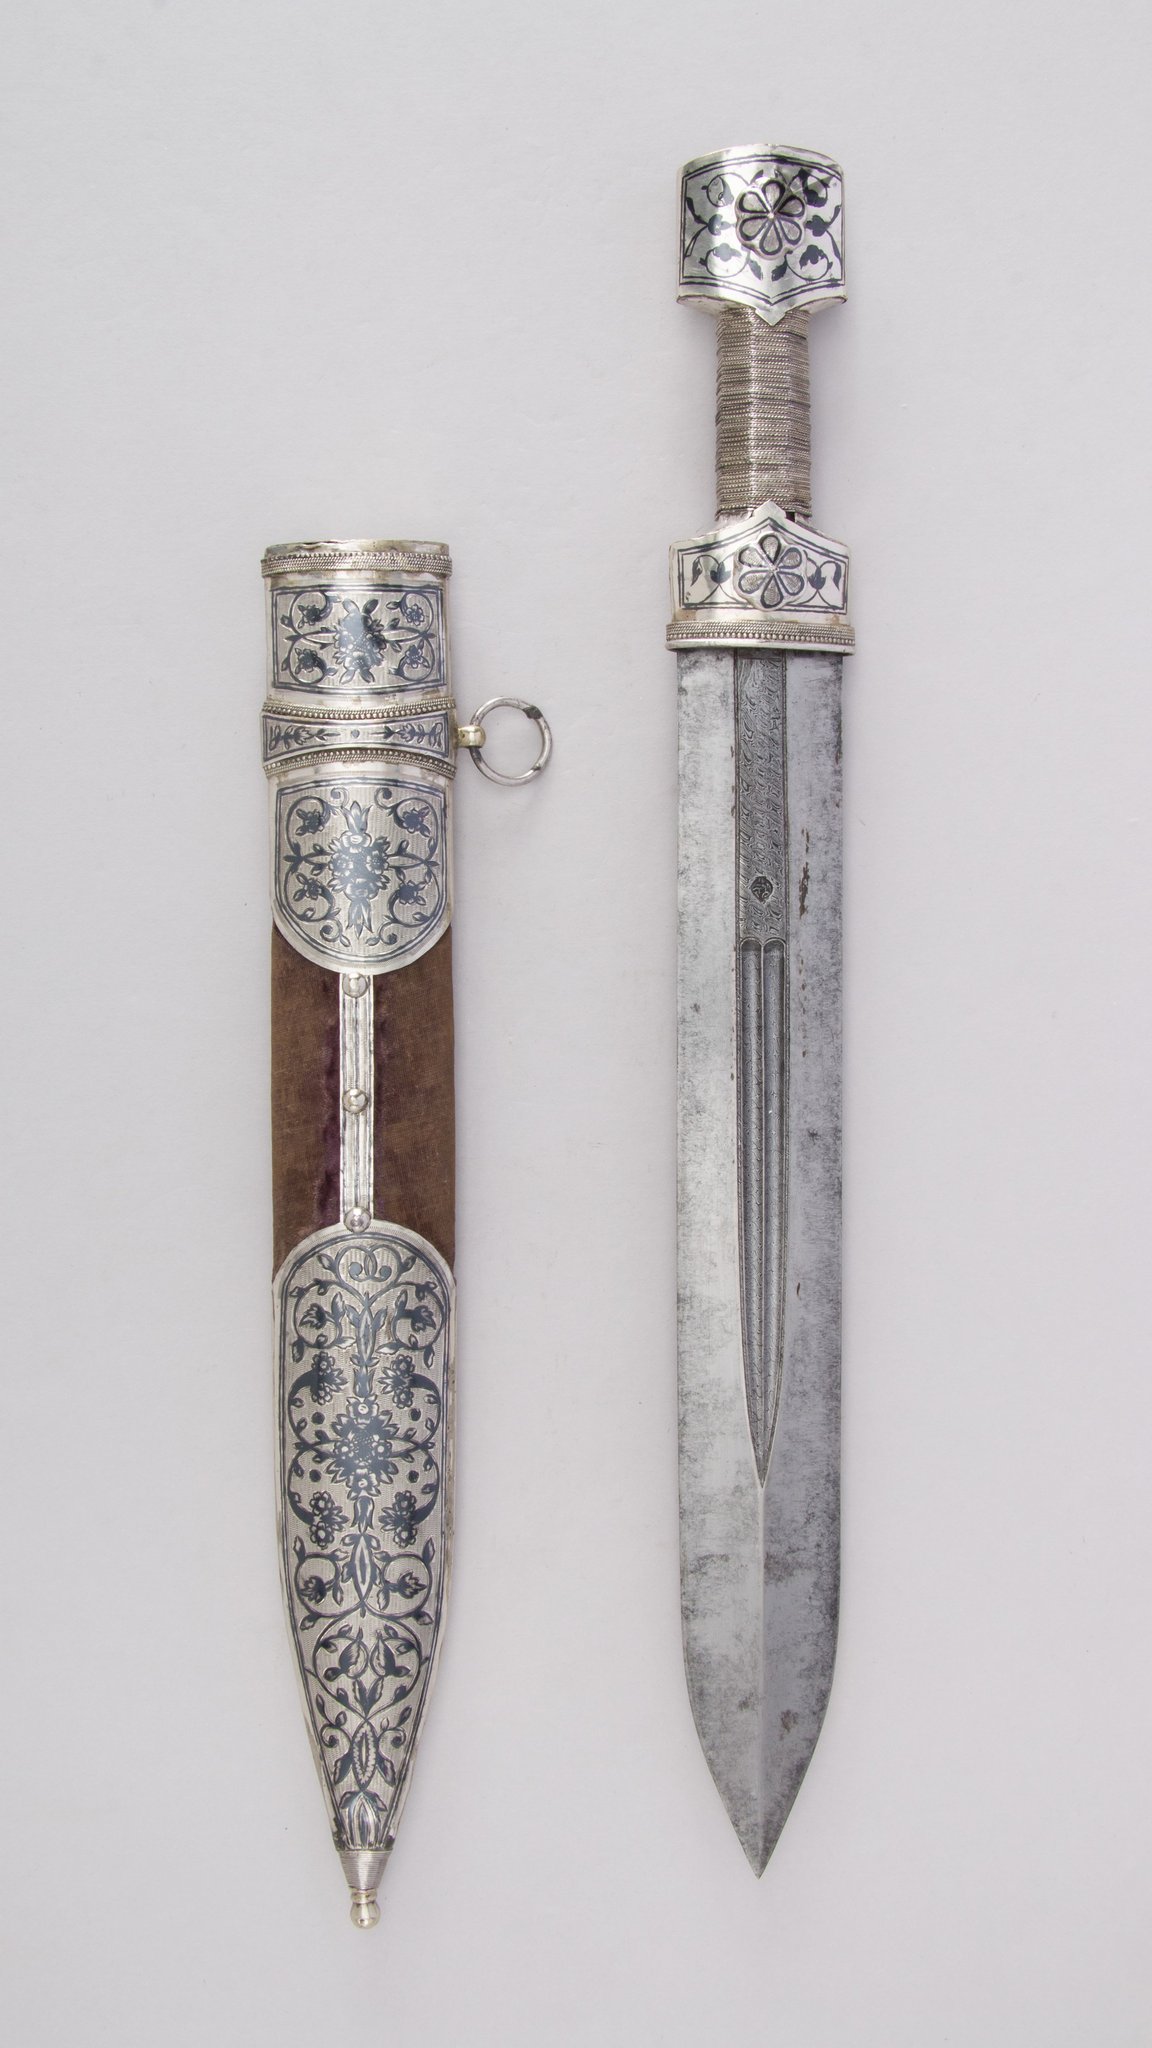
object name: dagger qama with sheath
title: Dagger (Qama) with Sheath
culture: caucasian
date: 1701-1900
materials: niello, silver, steel, textile, metal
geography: caucasus